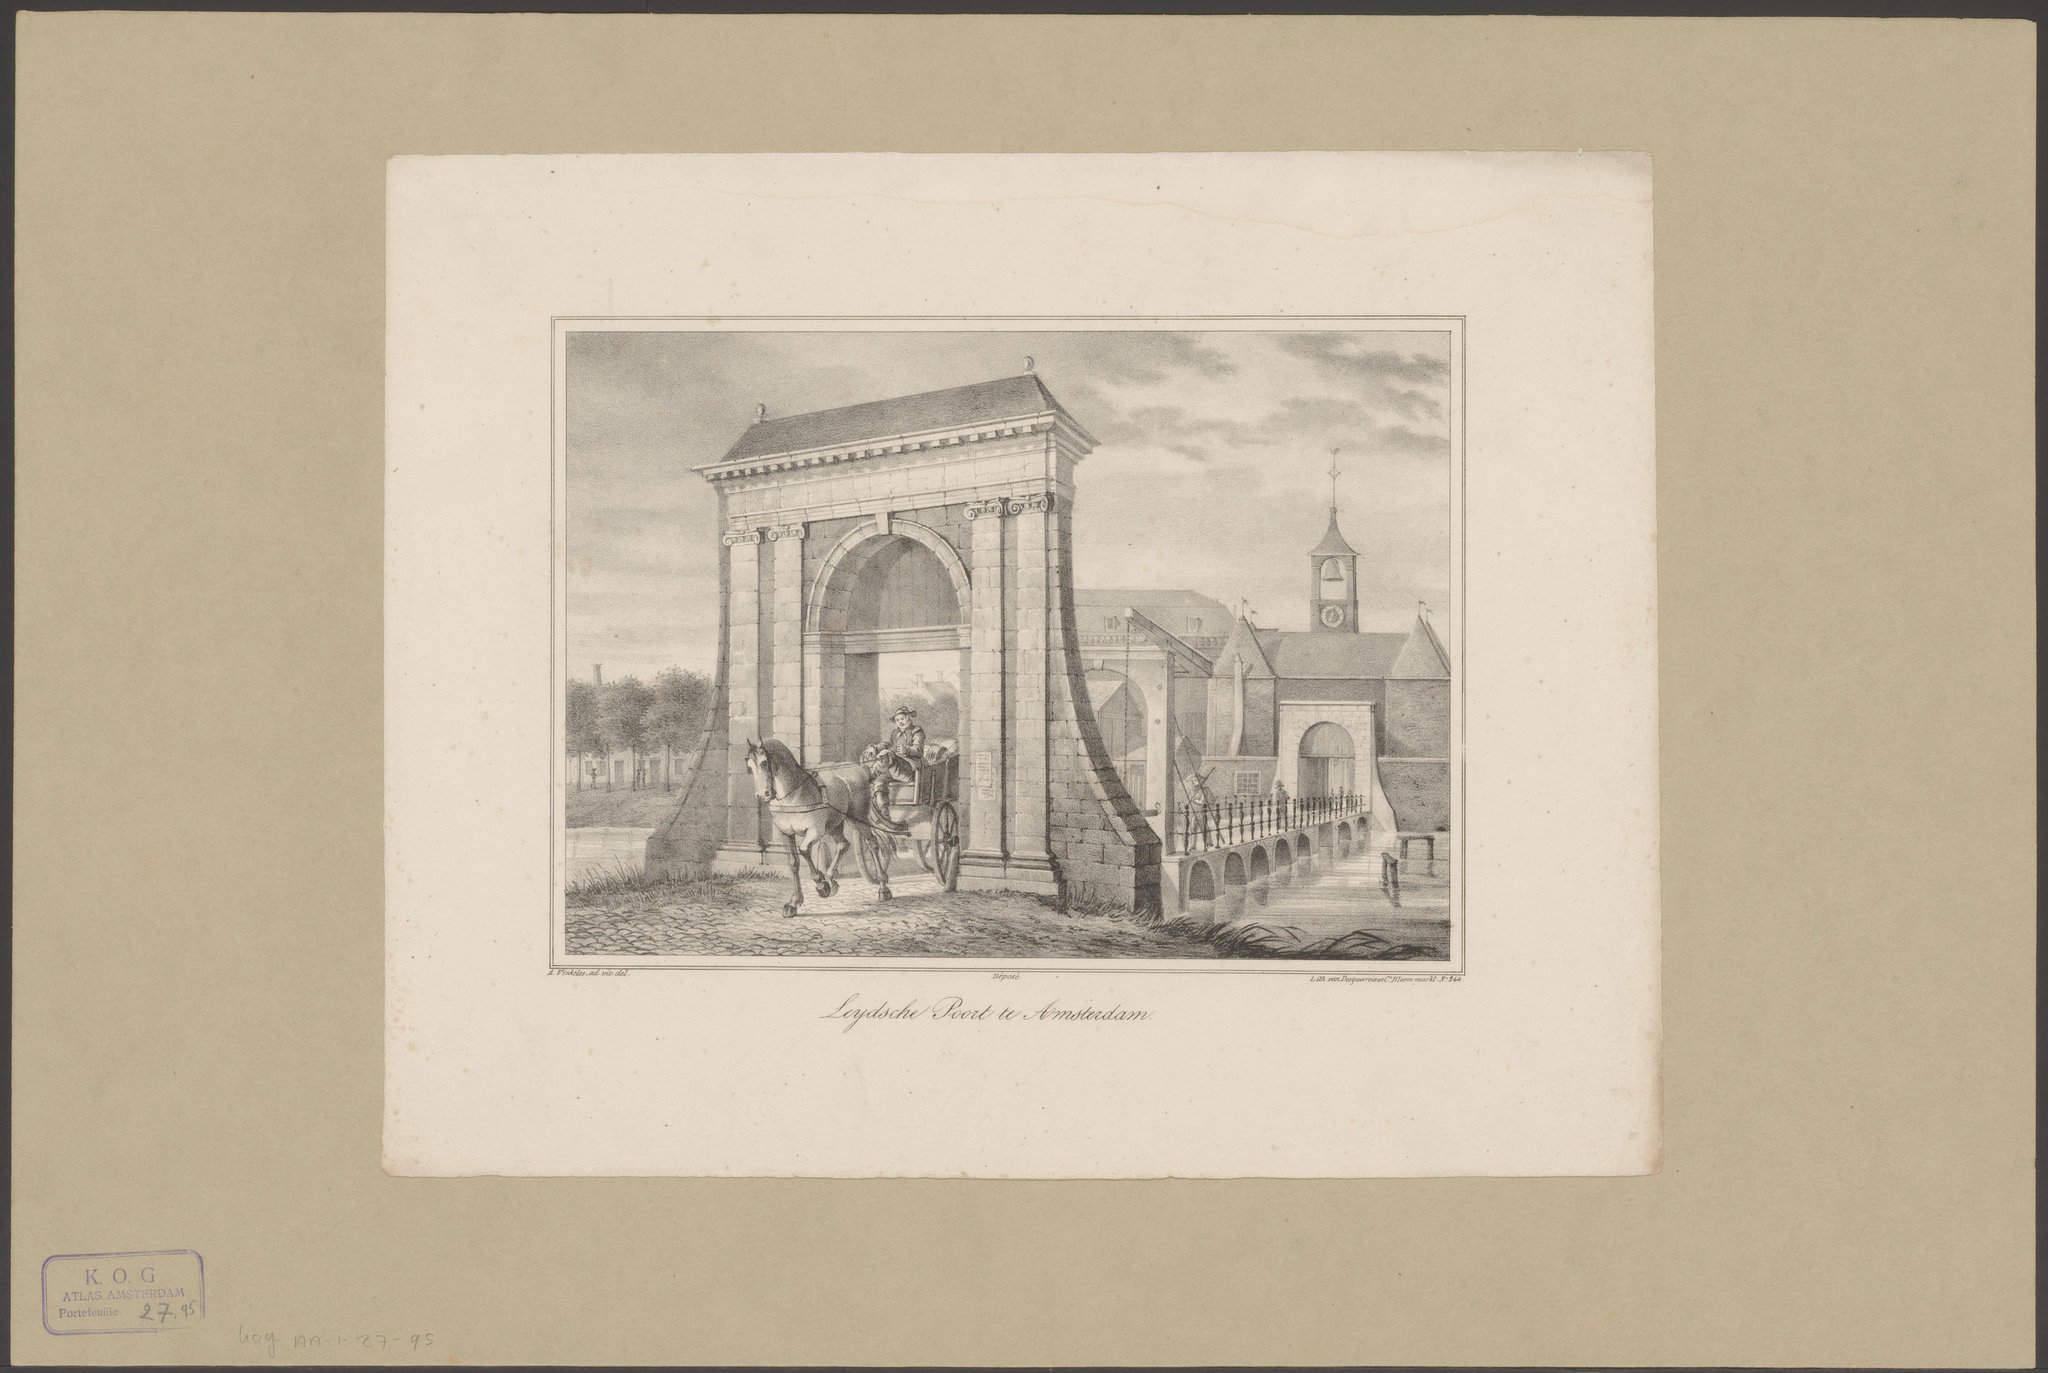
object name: print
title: Leydsche Poort te Amsterdam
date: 1828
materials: paper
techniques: lithograph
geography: amsterdam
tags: city-gate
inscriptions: collector's mark: Lugt 1641b, : ‘Déposé’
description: Onderdeel van een omslag met een serie van zes lithografieën van Amsterdamse poorten. Onderwerpsrubriek binnen de Atlas Amsterdam: Poorten, verzamelbladen, F. Leidsepoort.